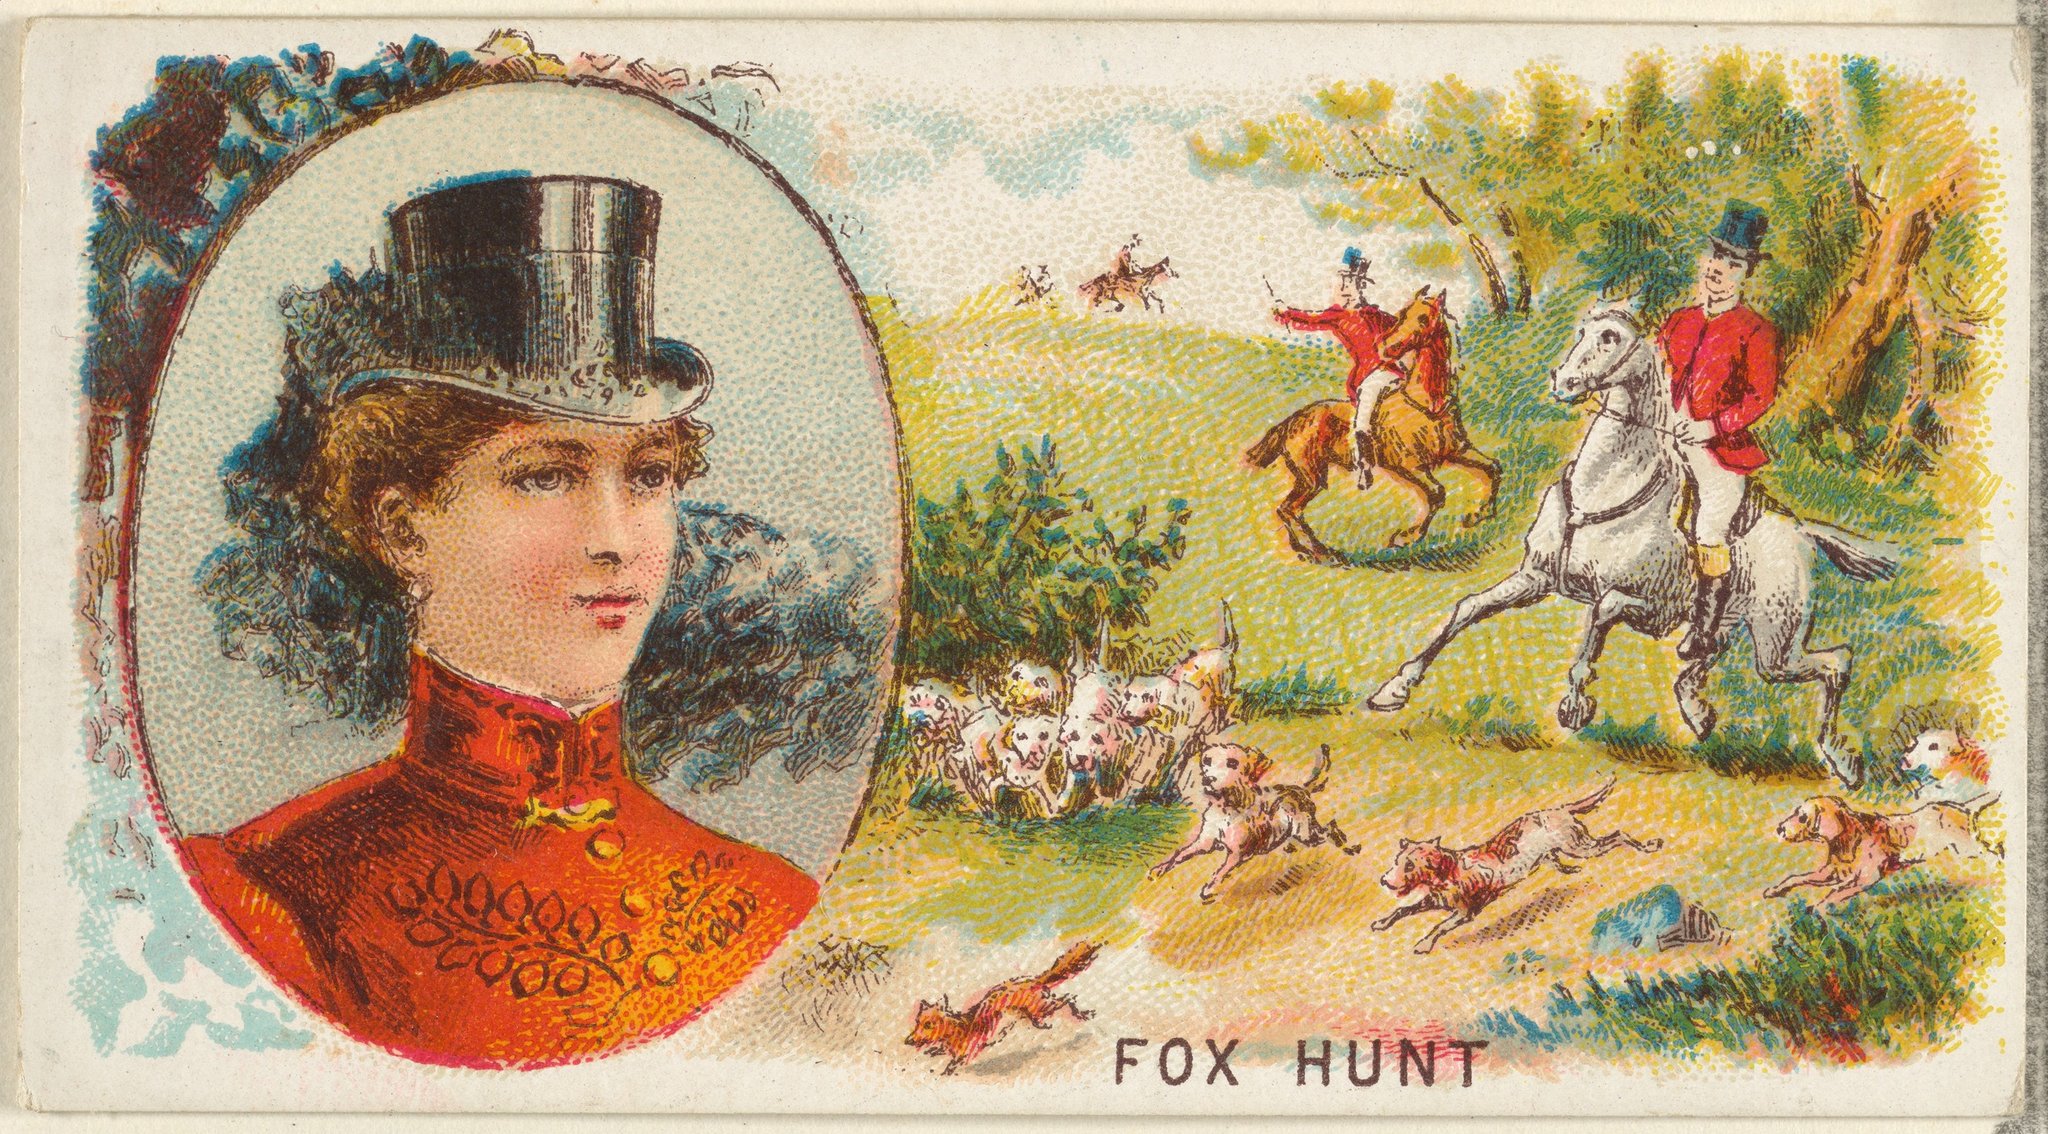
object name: print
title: Fox Hunt, from the Games and Sports series (N165) for Old Judge Cigarettes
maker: goodwin & company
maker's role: publisher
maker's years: 1850-1950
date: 1889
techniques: color lithograph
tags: women,dogs,foxes,horses